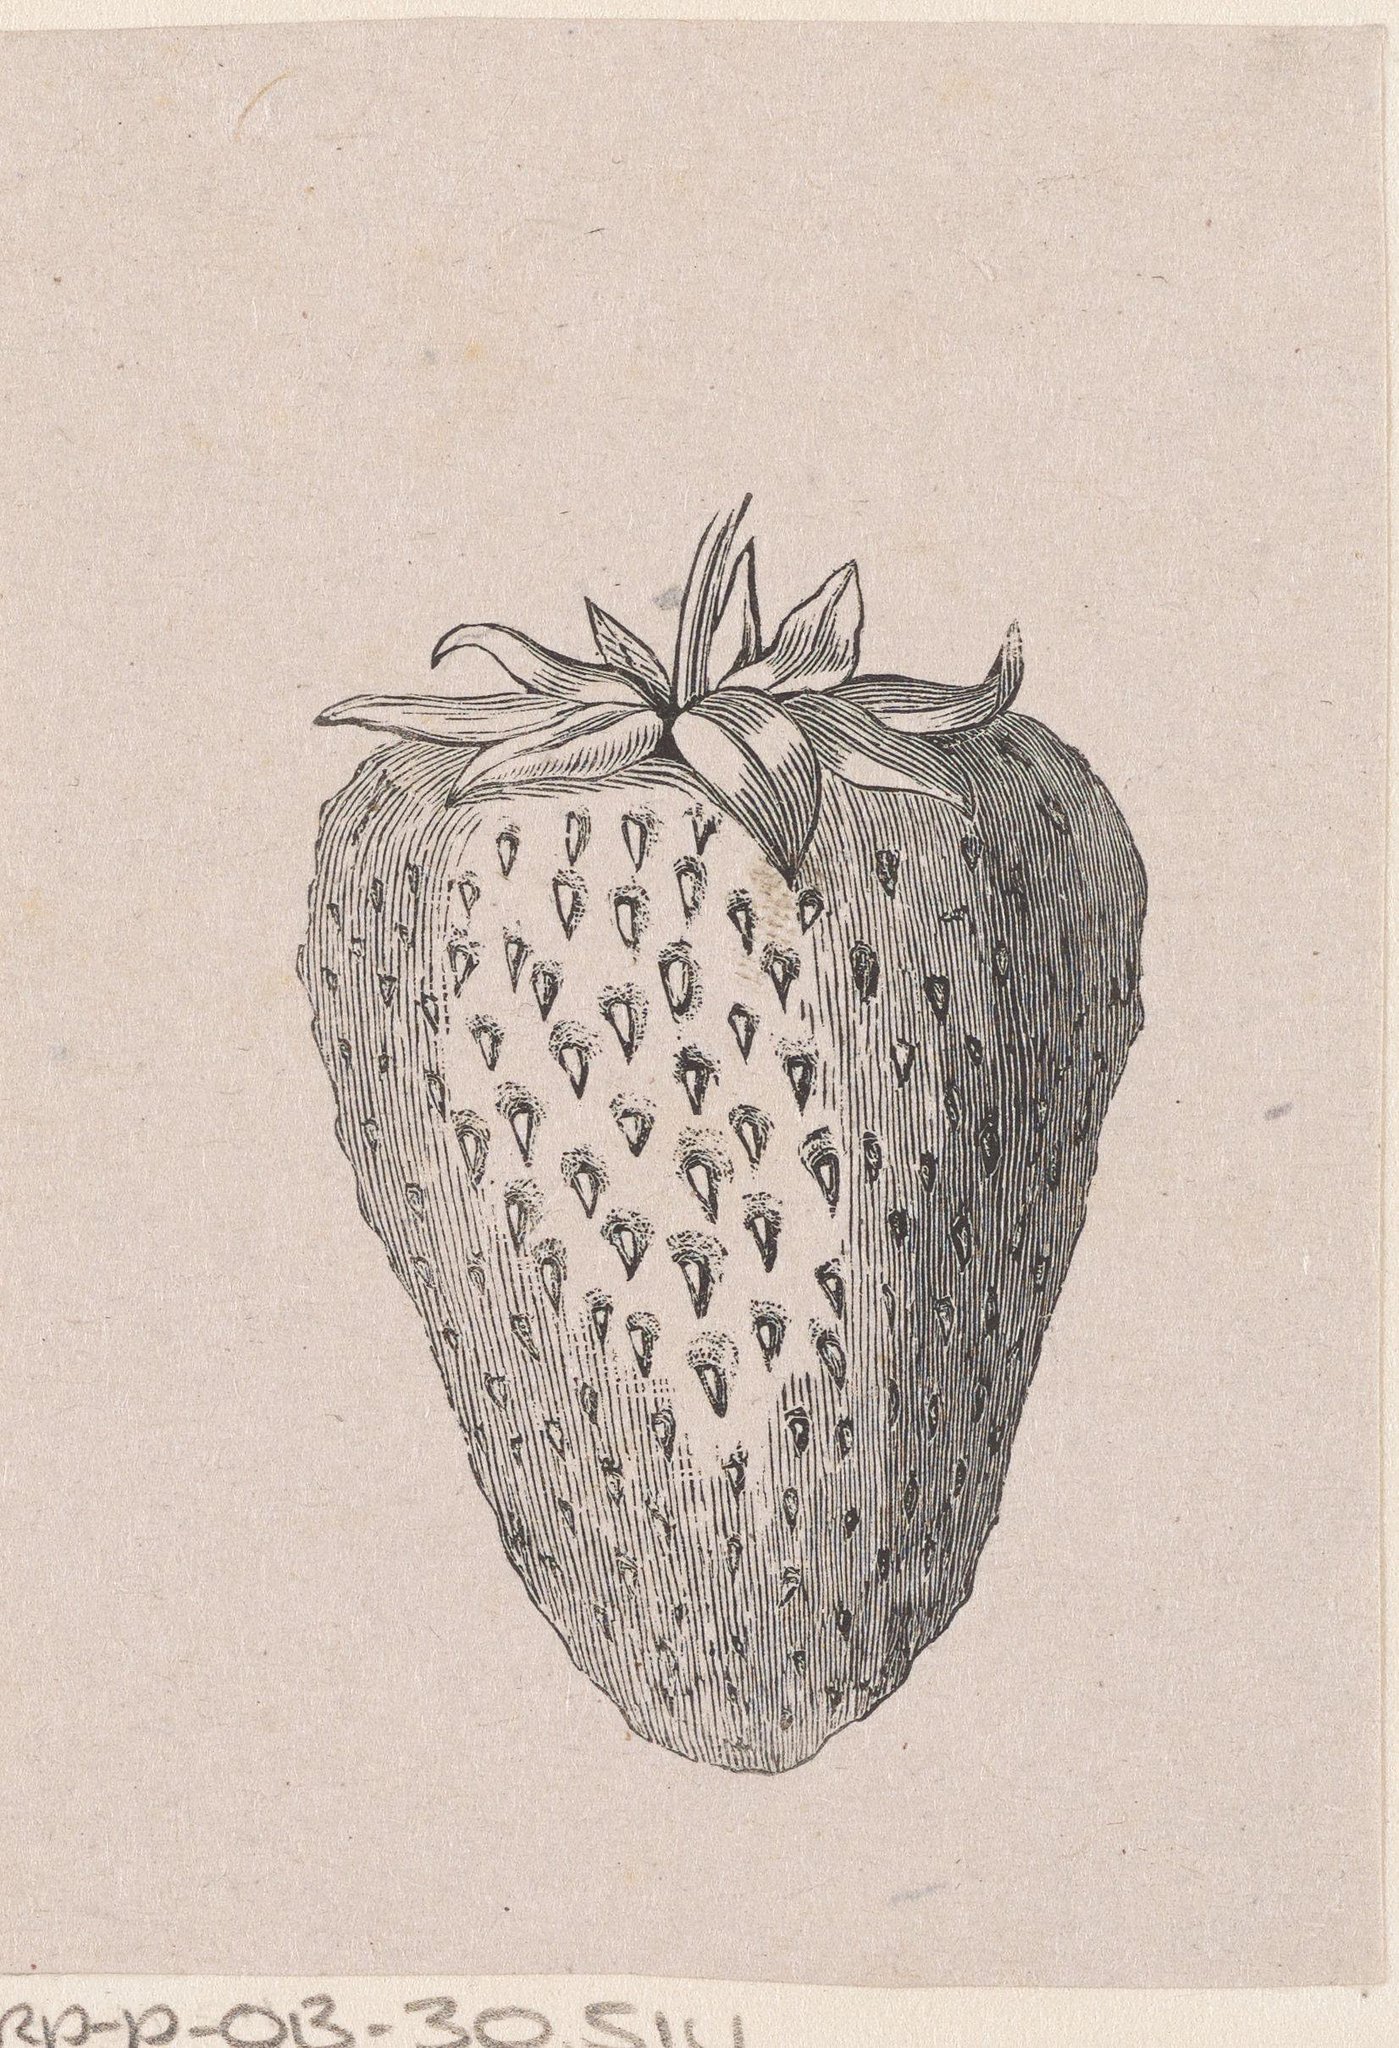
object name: print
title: Aardbei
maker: isaac weissenbruch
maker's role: print maker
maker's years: 1826-1912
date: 1836-1912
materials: paper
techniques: engraving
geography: netherlands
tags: fruits: strawberry